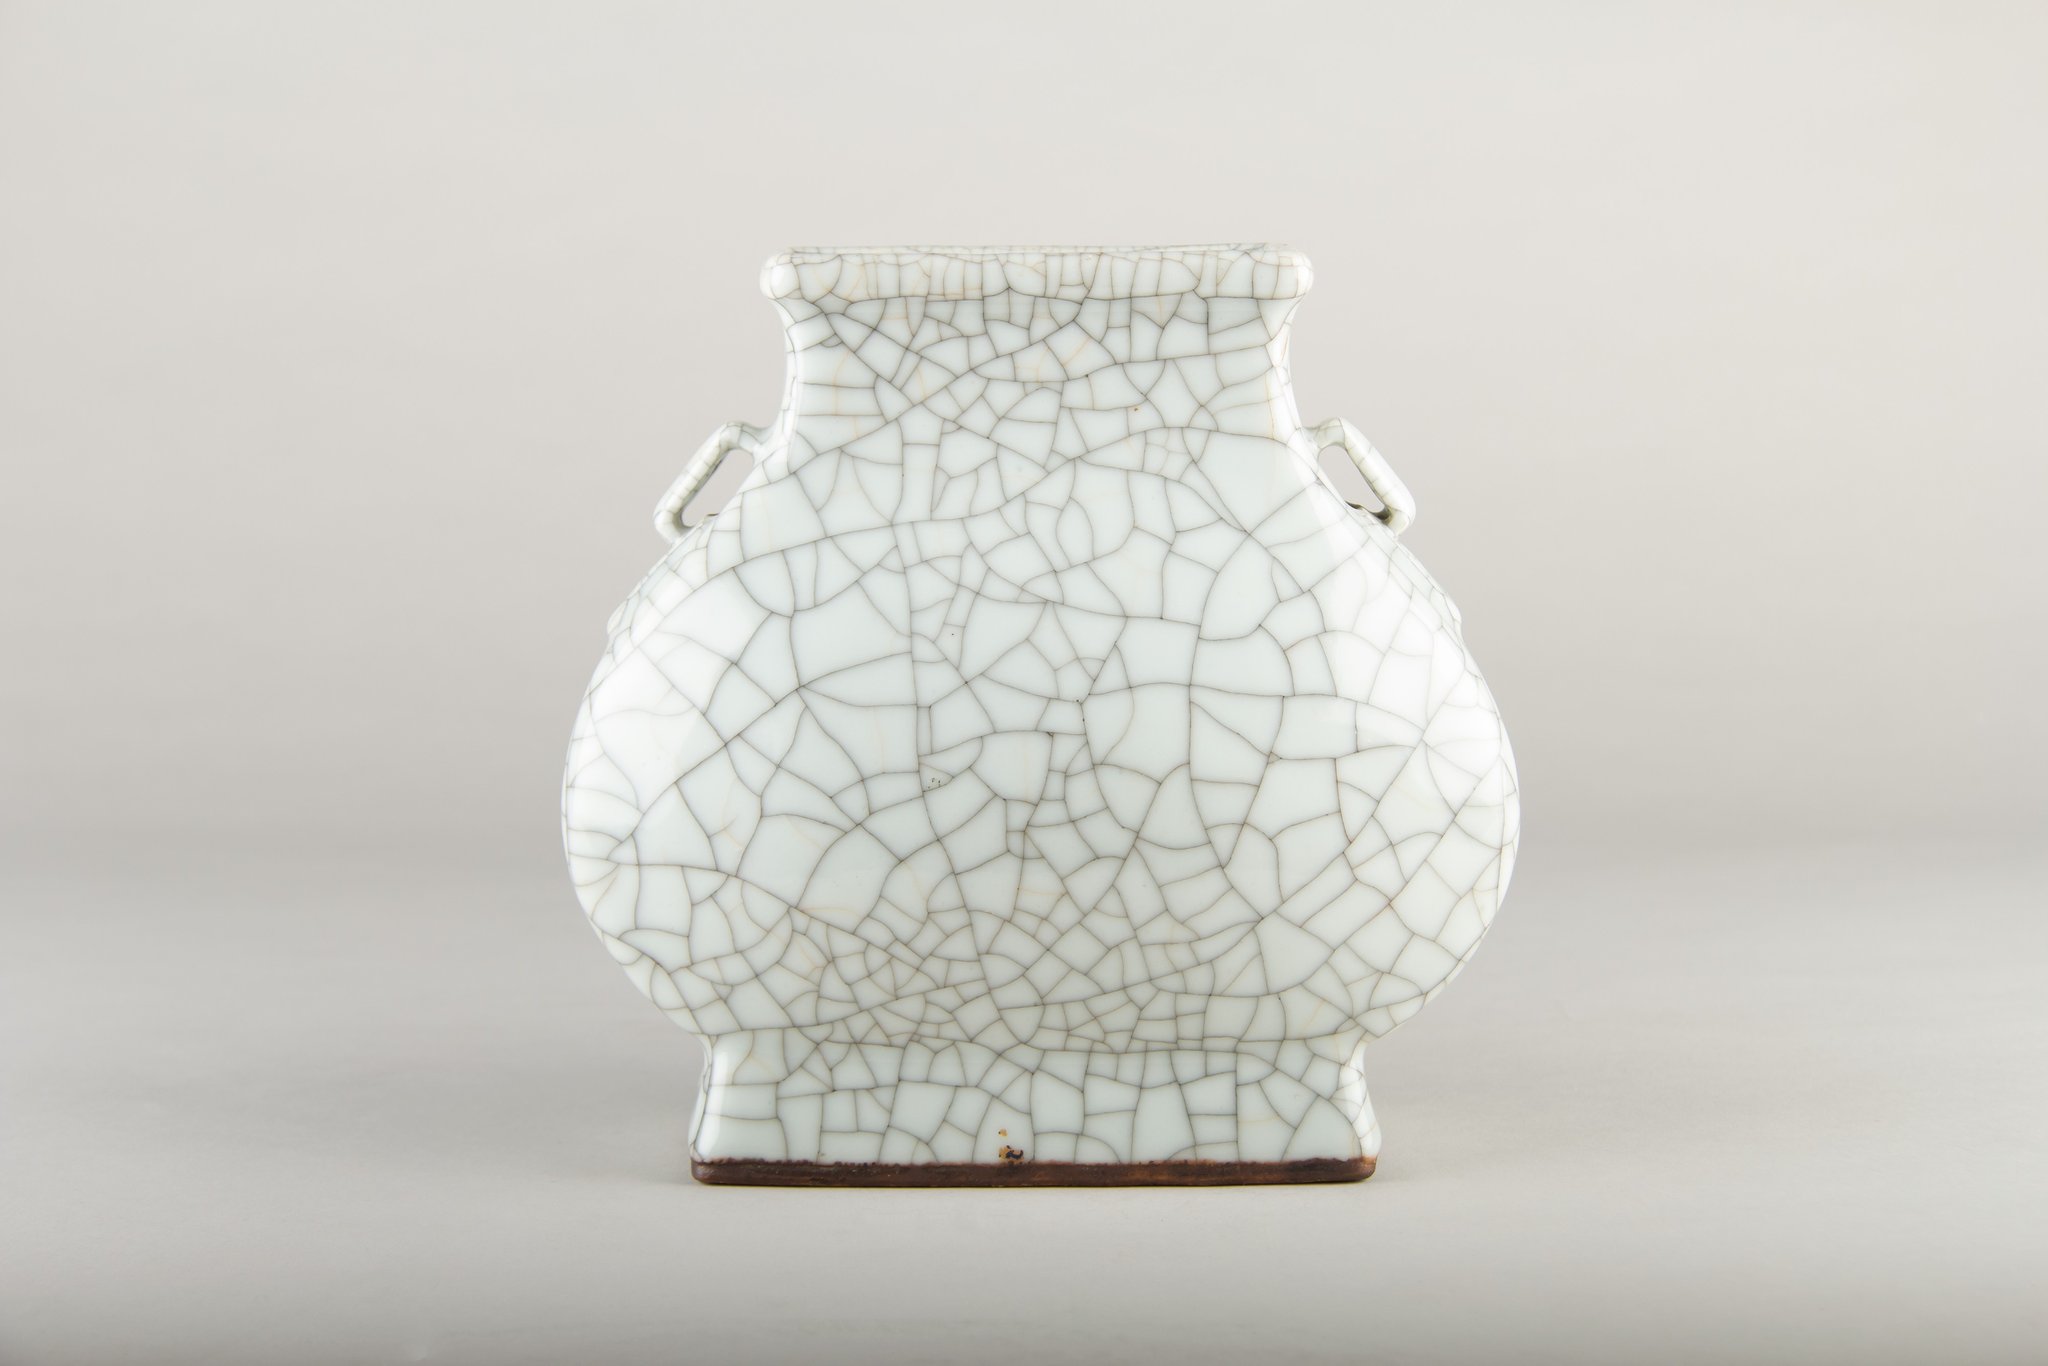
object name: vase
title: Flask vase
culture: chinese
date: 1701-1800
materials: glaze, porcelain